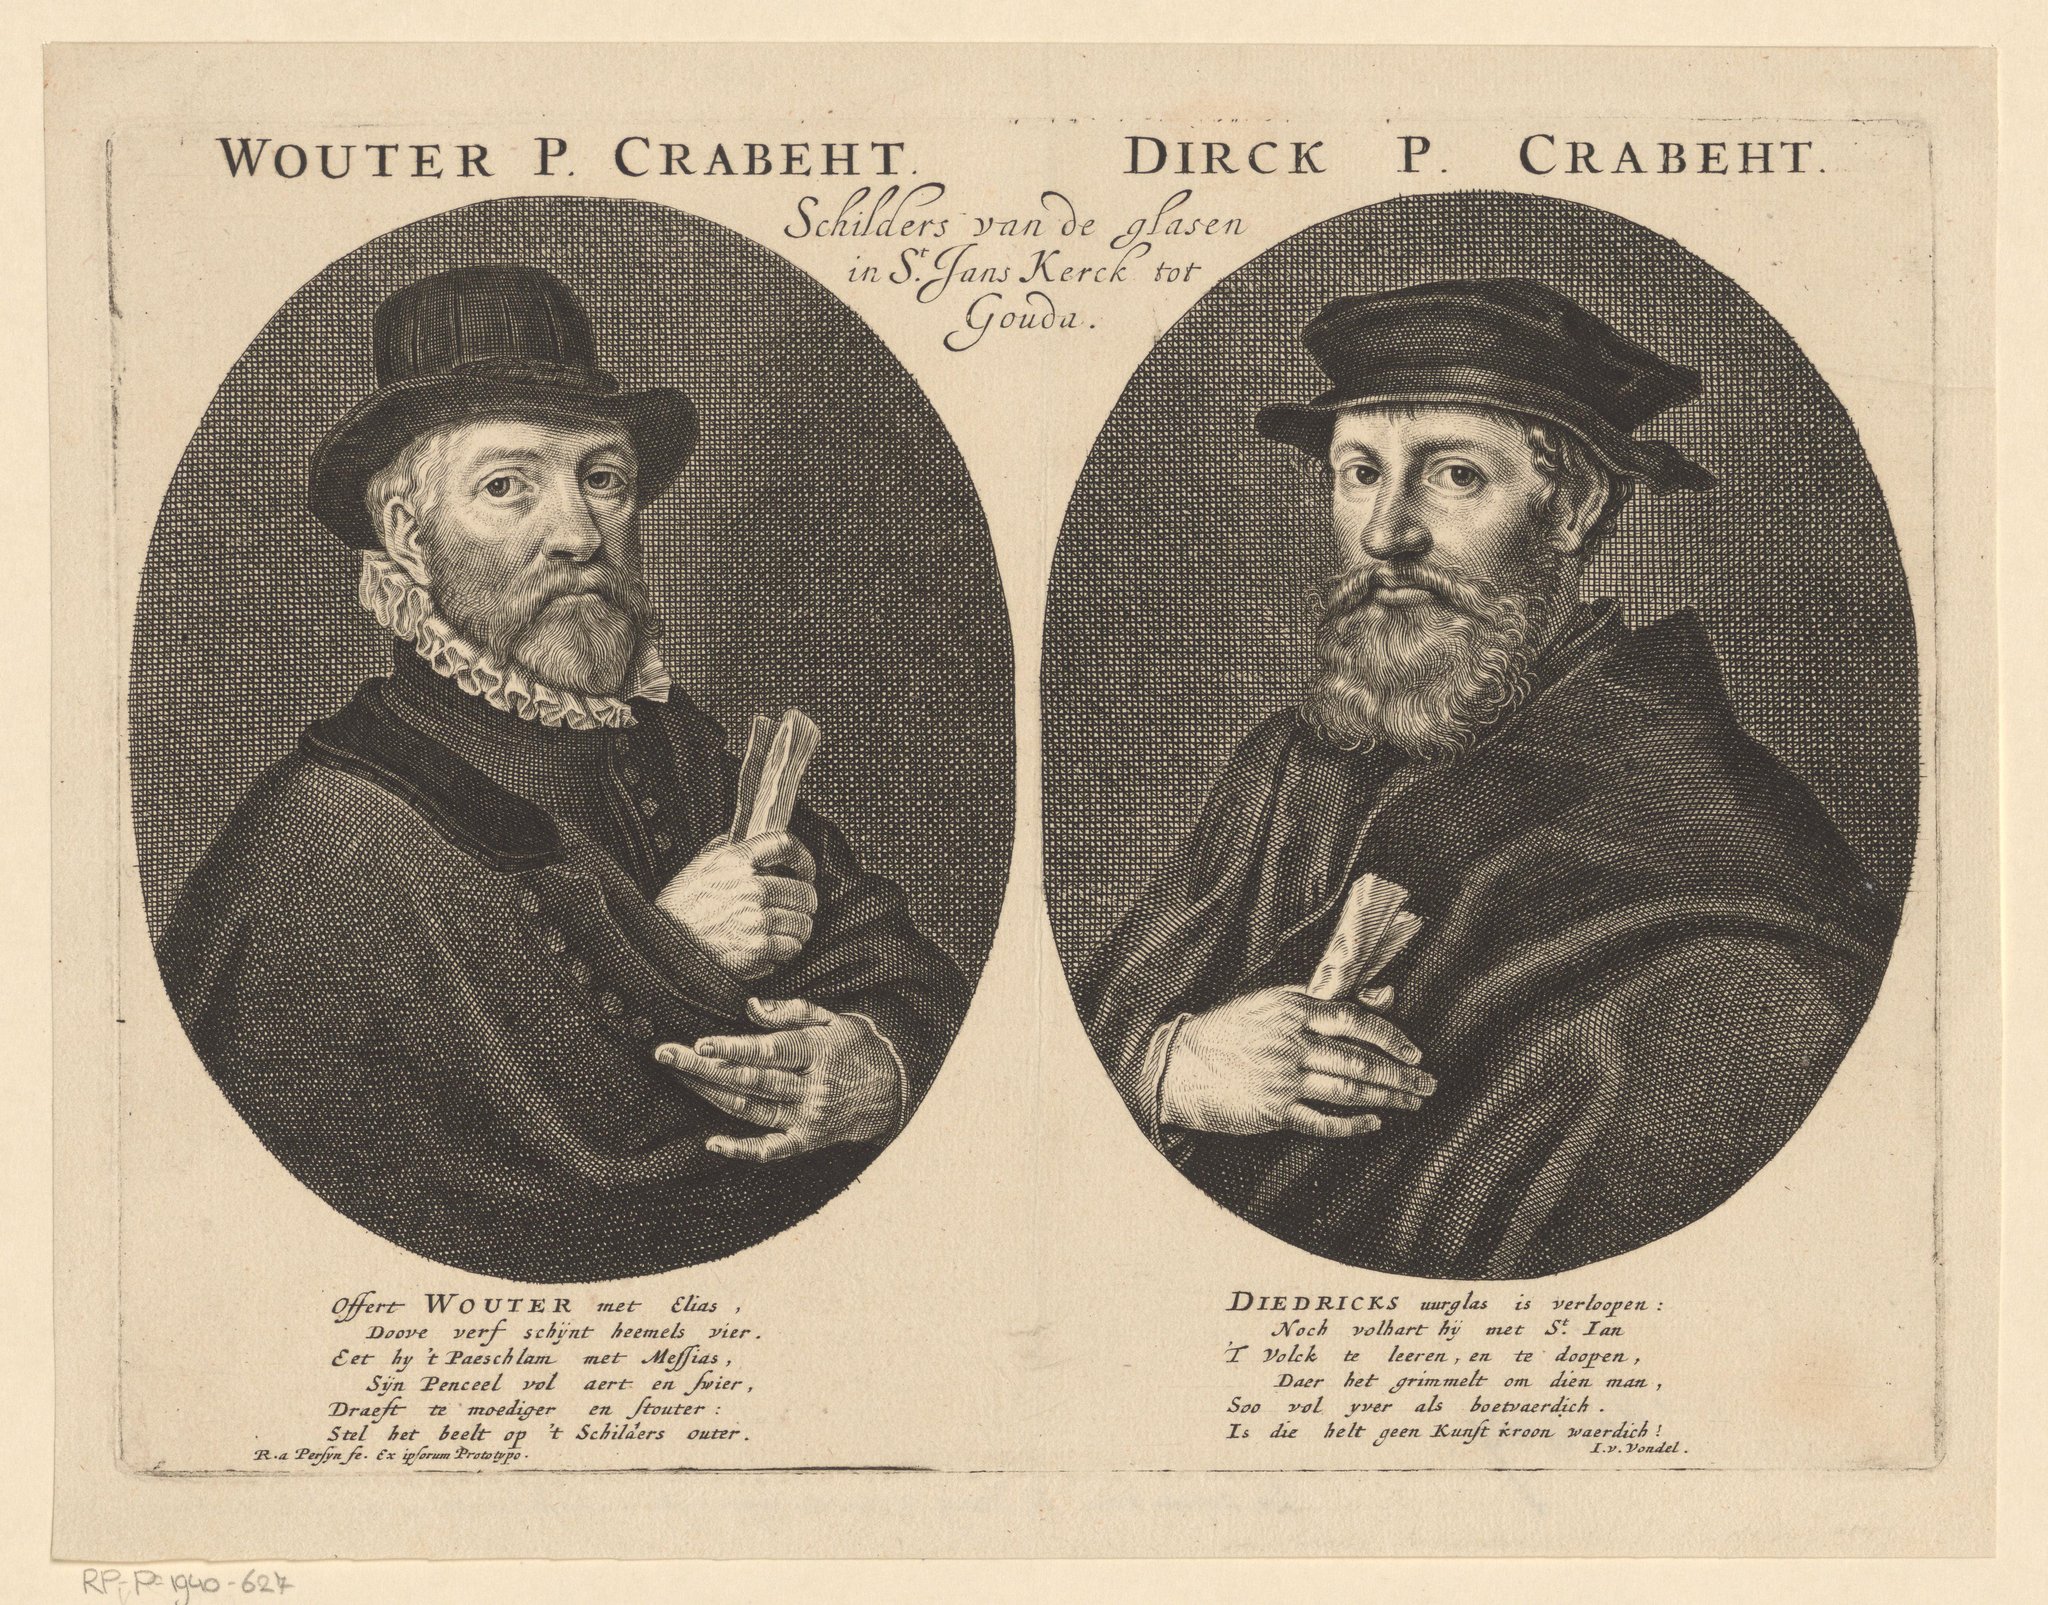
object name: print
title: Portret van Dirck Pietersz. Crabeth en Wouter Pietersz. Crabeth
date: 1646-1668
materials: paper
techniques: engraving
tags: dirck pietersz. crabeth, gouda, draughtsman, designer, wouter pietersz i crabeth, historical persons, portrait, self-portrait of painter